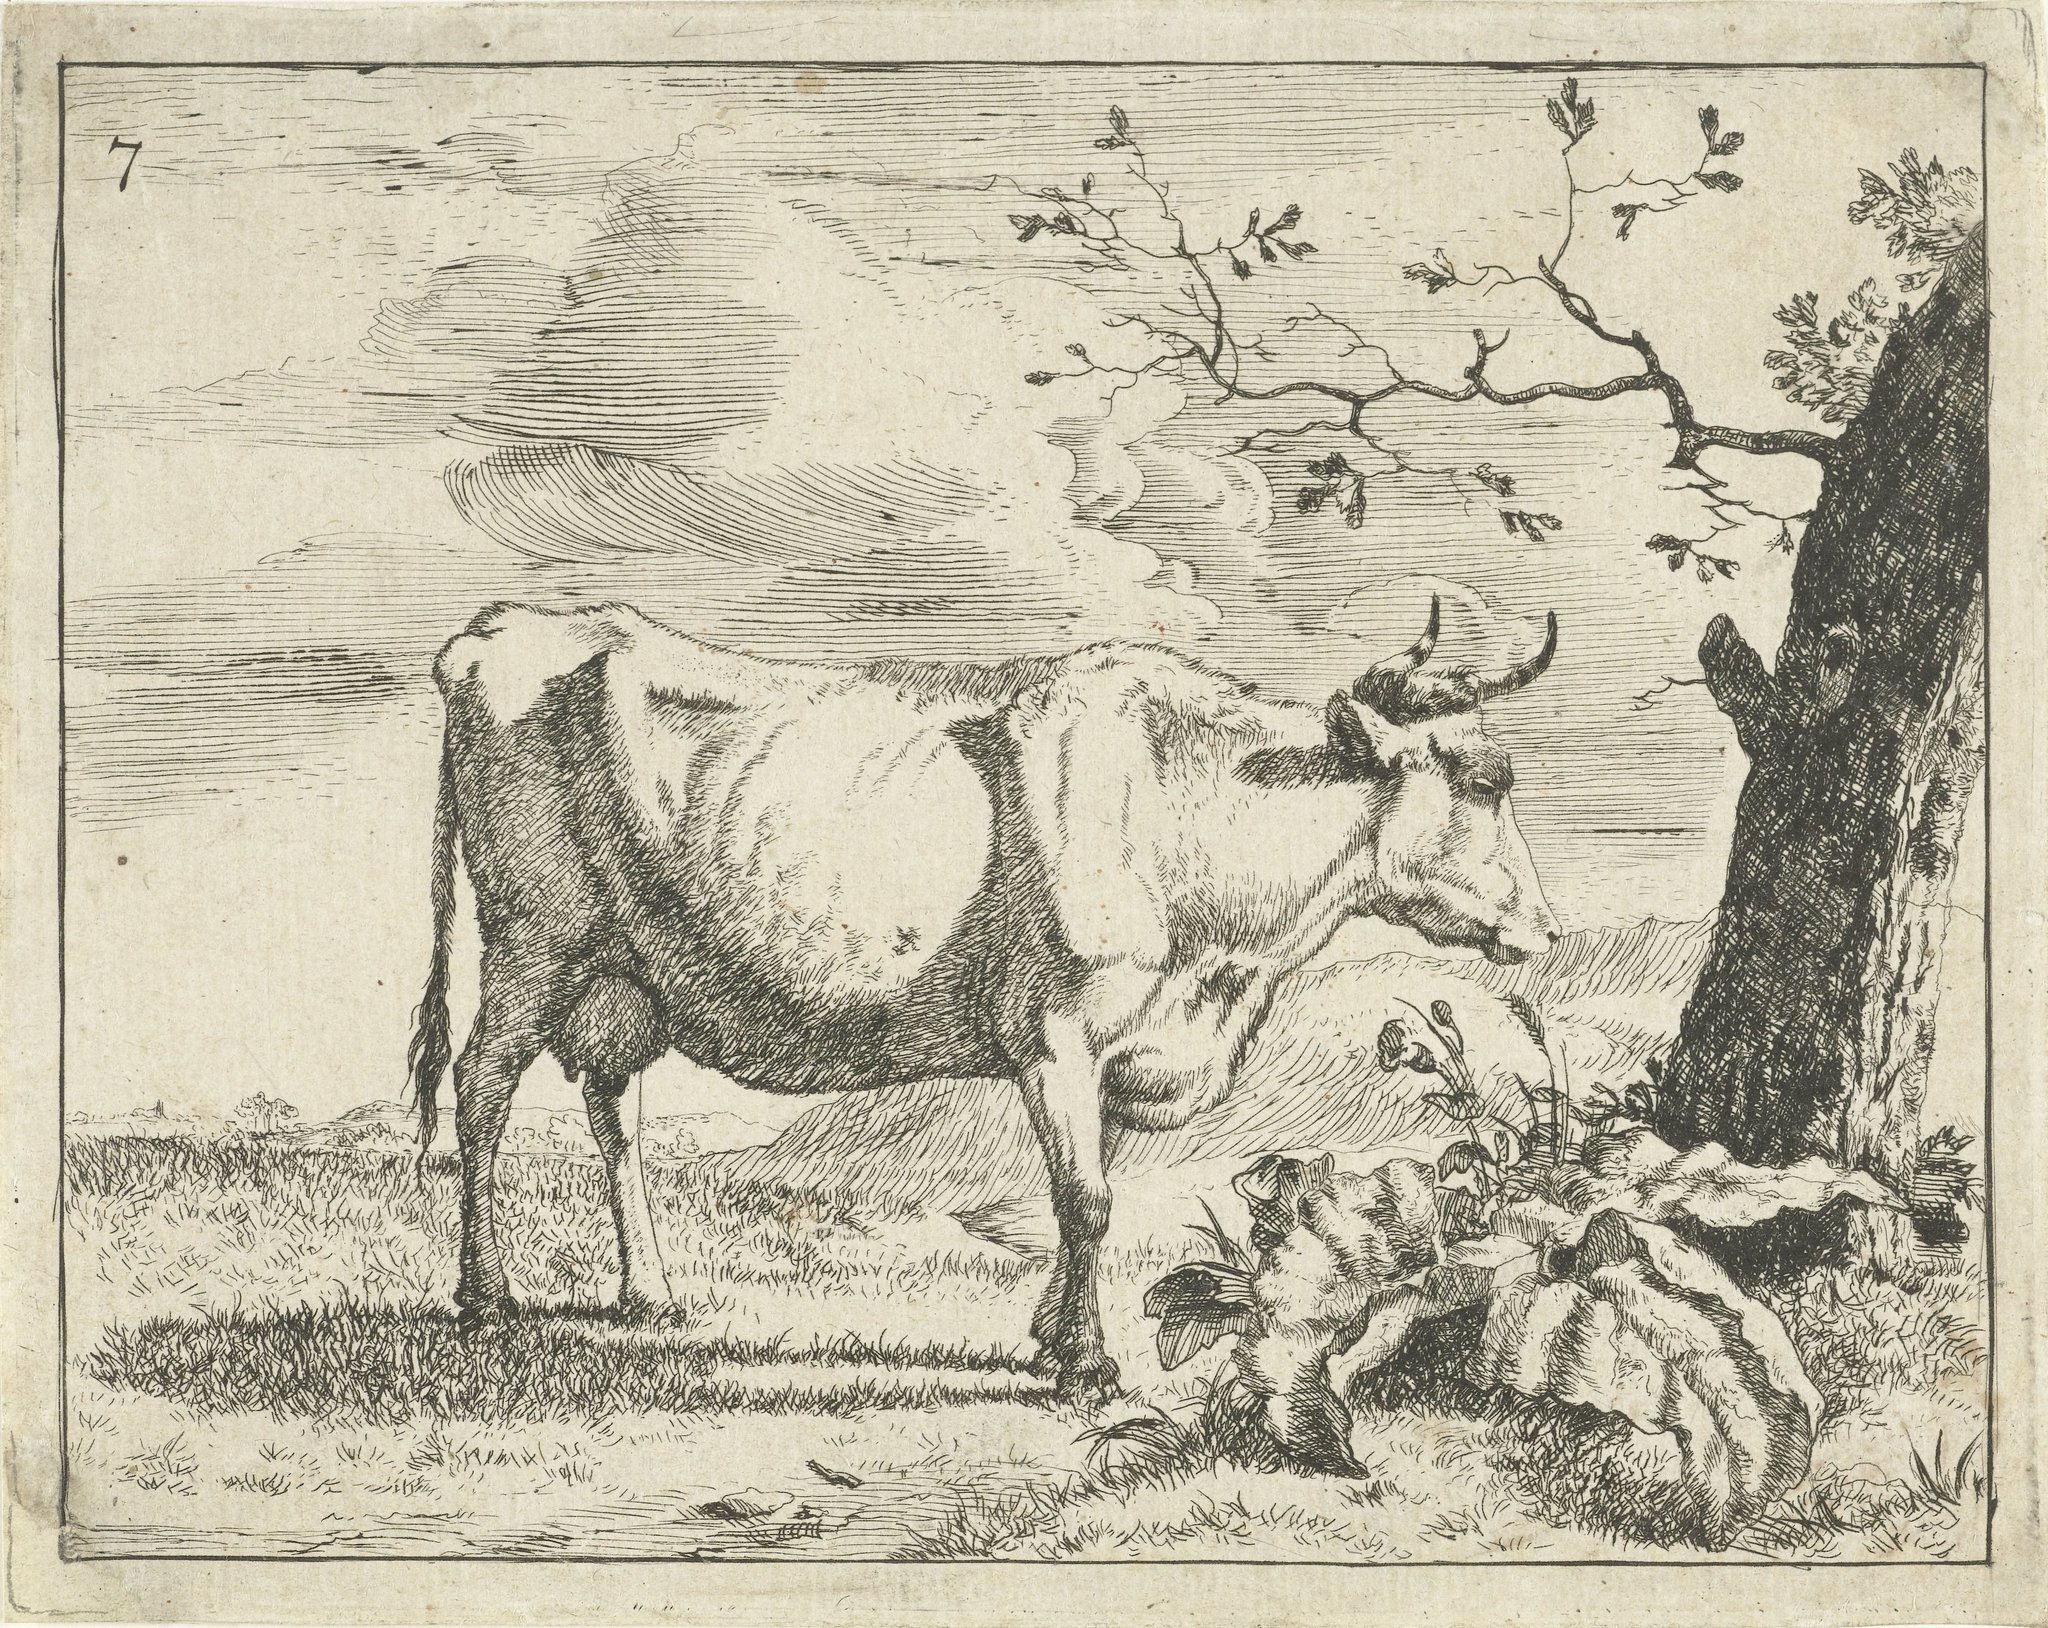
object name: print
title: Staande koe bij boom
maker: marcus de bye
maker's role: print maker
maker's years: 1639-1688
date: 1657-1677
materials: paper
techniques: etching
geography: the hague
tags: cow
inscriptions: collector's mark: Lugt 240